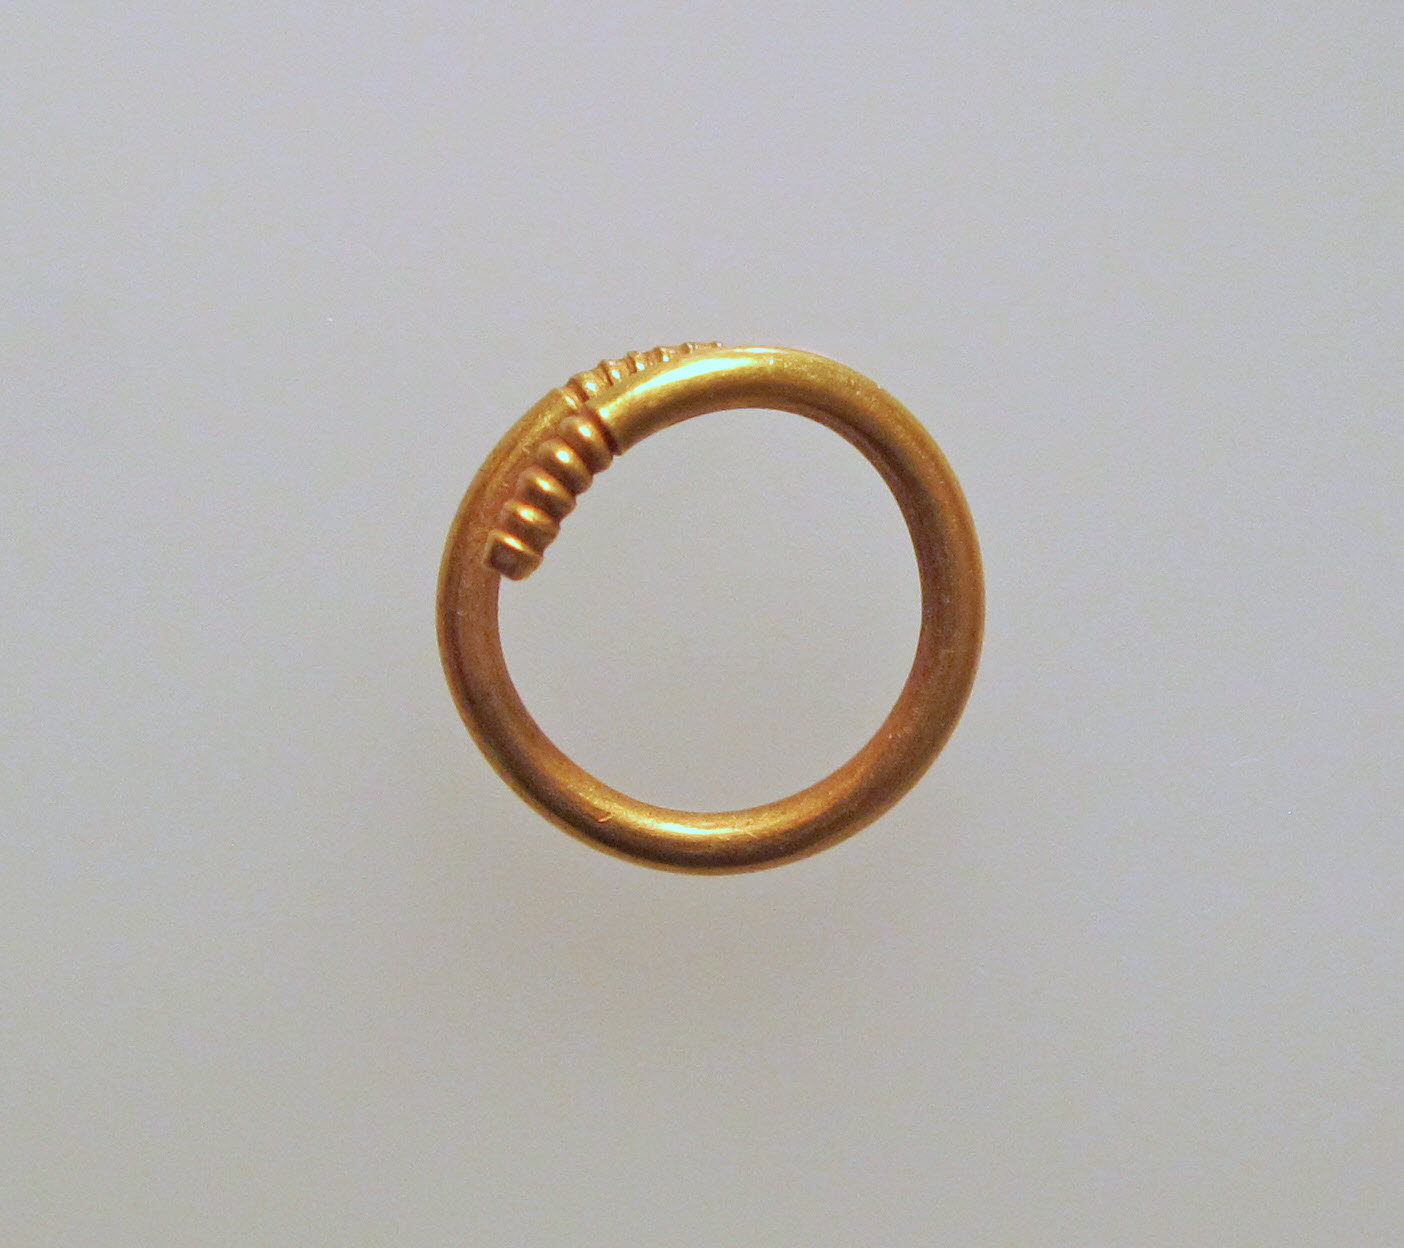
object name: spiral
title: Spirals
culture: cypriot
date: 3900 BCE-100 CE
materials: gold